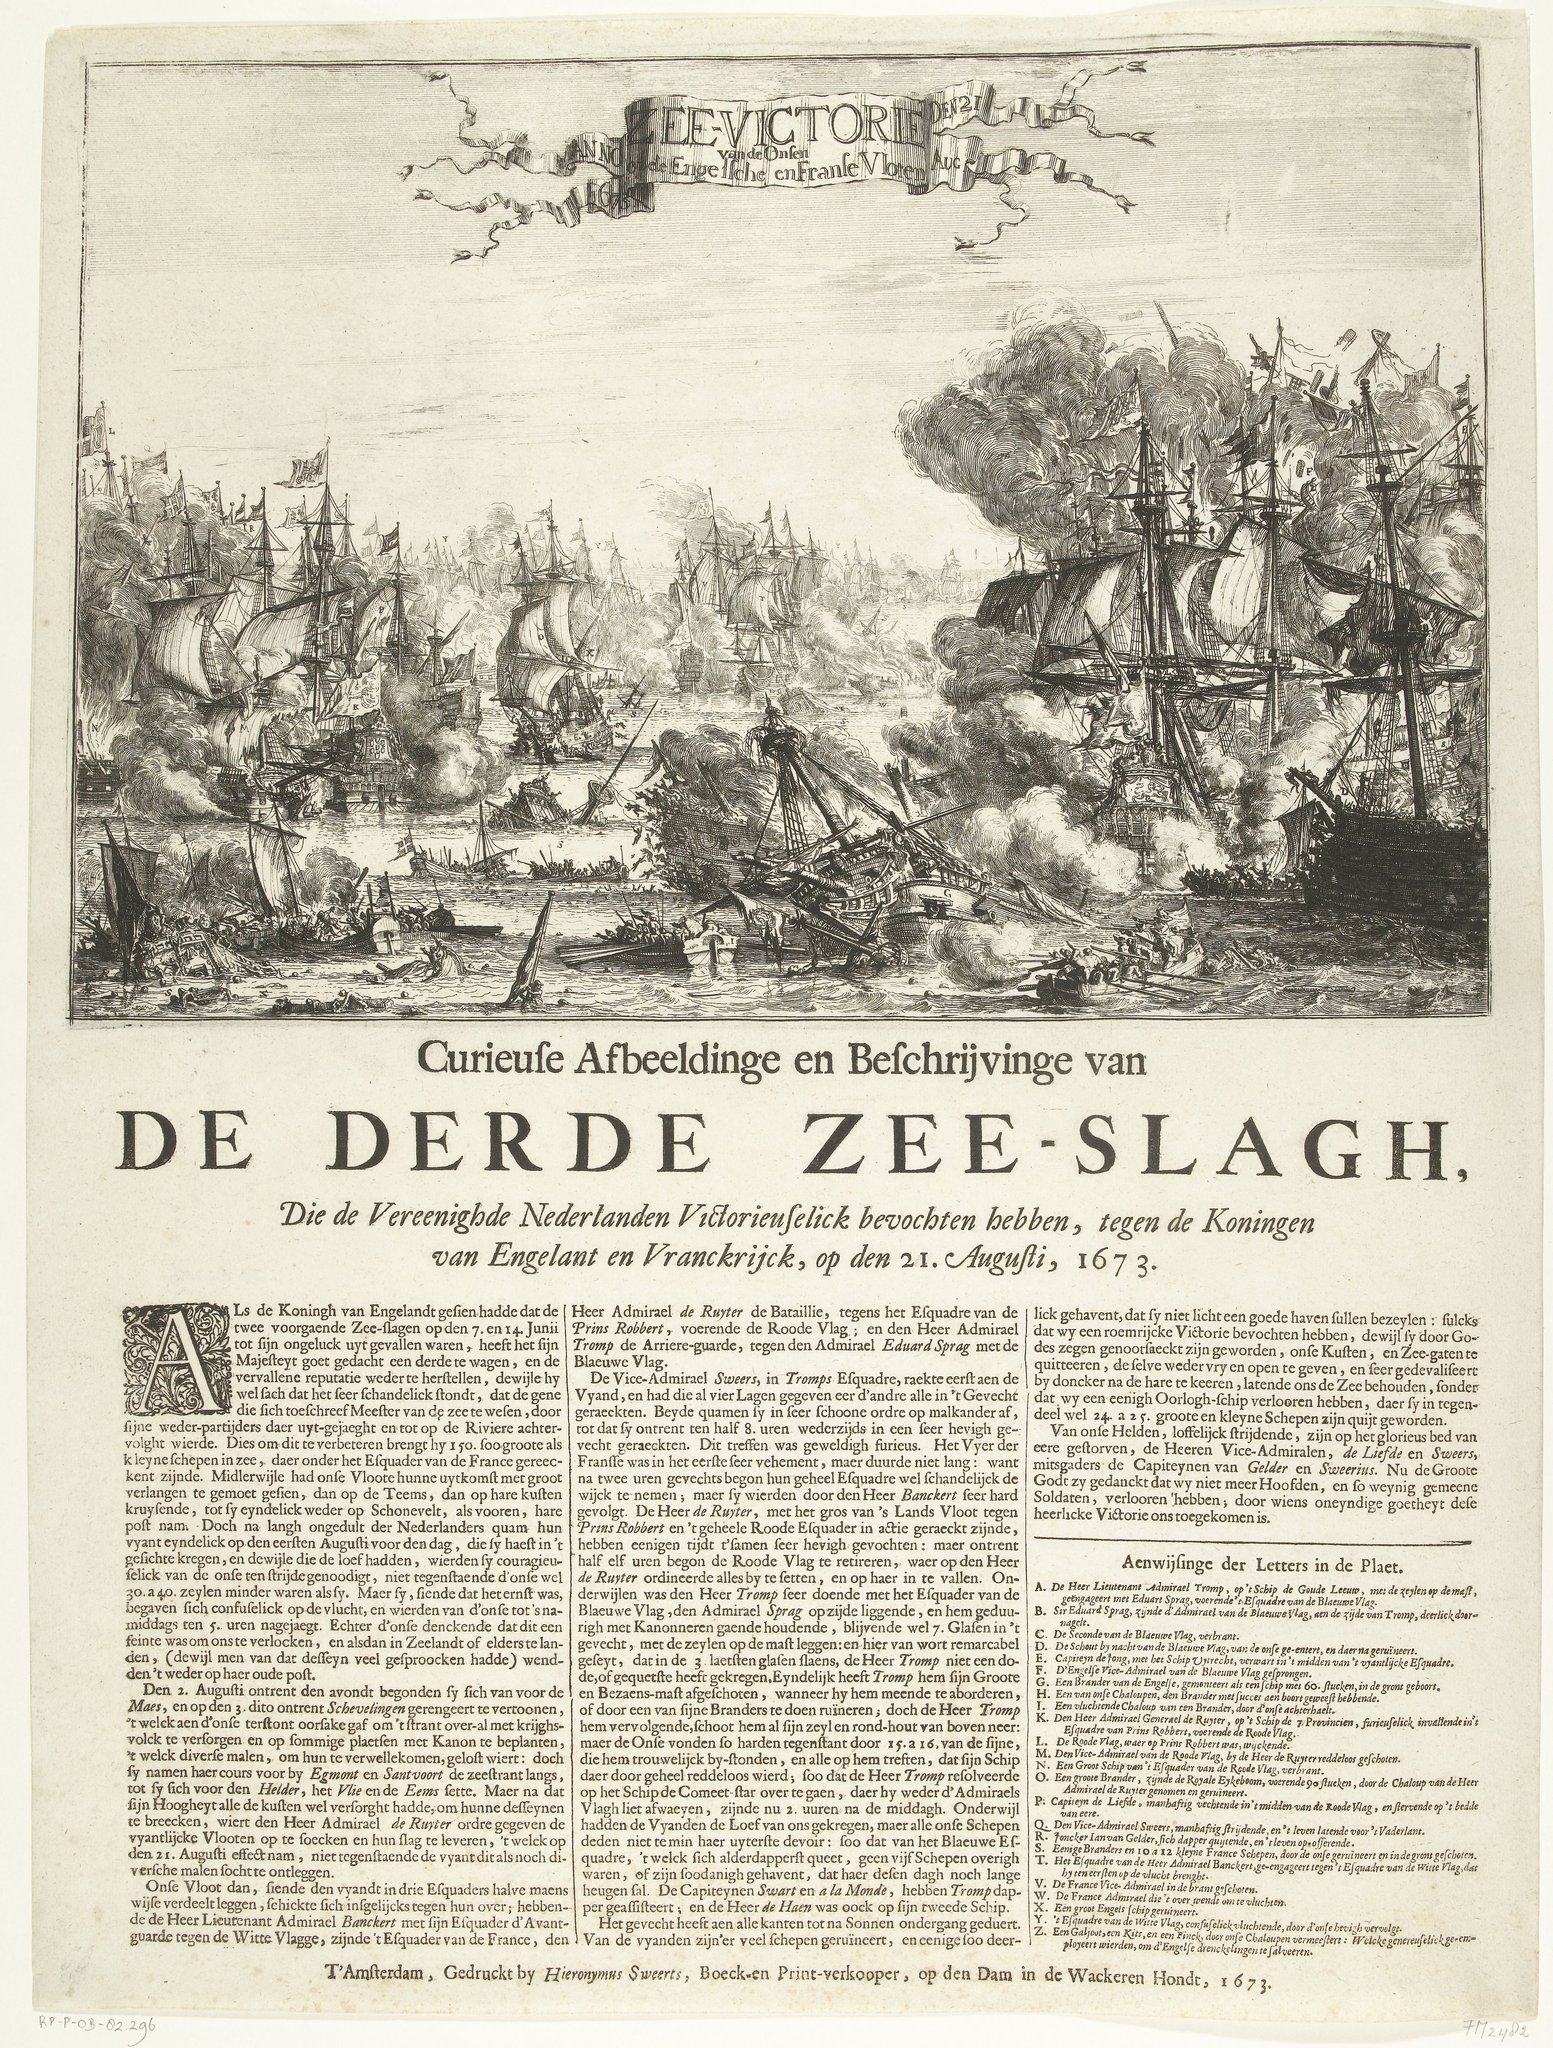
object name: print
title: Zeeslag bij Kijkduin op 21 augustus 1673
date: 1673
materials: paper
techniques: etching, letterpress printing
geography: amsterdam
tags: prague, painter, print maker, prinz ruprecht, flushing, michiel adriaenszoon de ruyter, rotterdam, amsterdam, cornelis tromp, battle (+ naval force), battle of the texel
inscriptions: date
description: Zeeslag bij Kijkduin (bij Texel) op 21 augustus 1673 tussen de Staatse vloot onder Michiel Adriaenszoon de Ruyter en Cornelis Tromp en de Engels-Franse vloot onder prins Rupert en graaf Jean d'Estrées (II). Grote voorstelling van de zeeslag met brandende en zinkende schepen. Op het blad onder de plaat een beschrijving in 3 kolommen met de legenda A-Z.